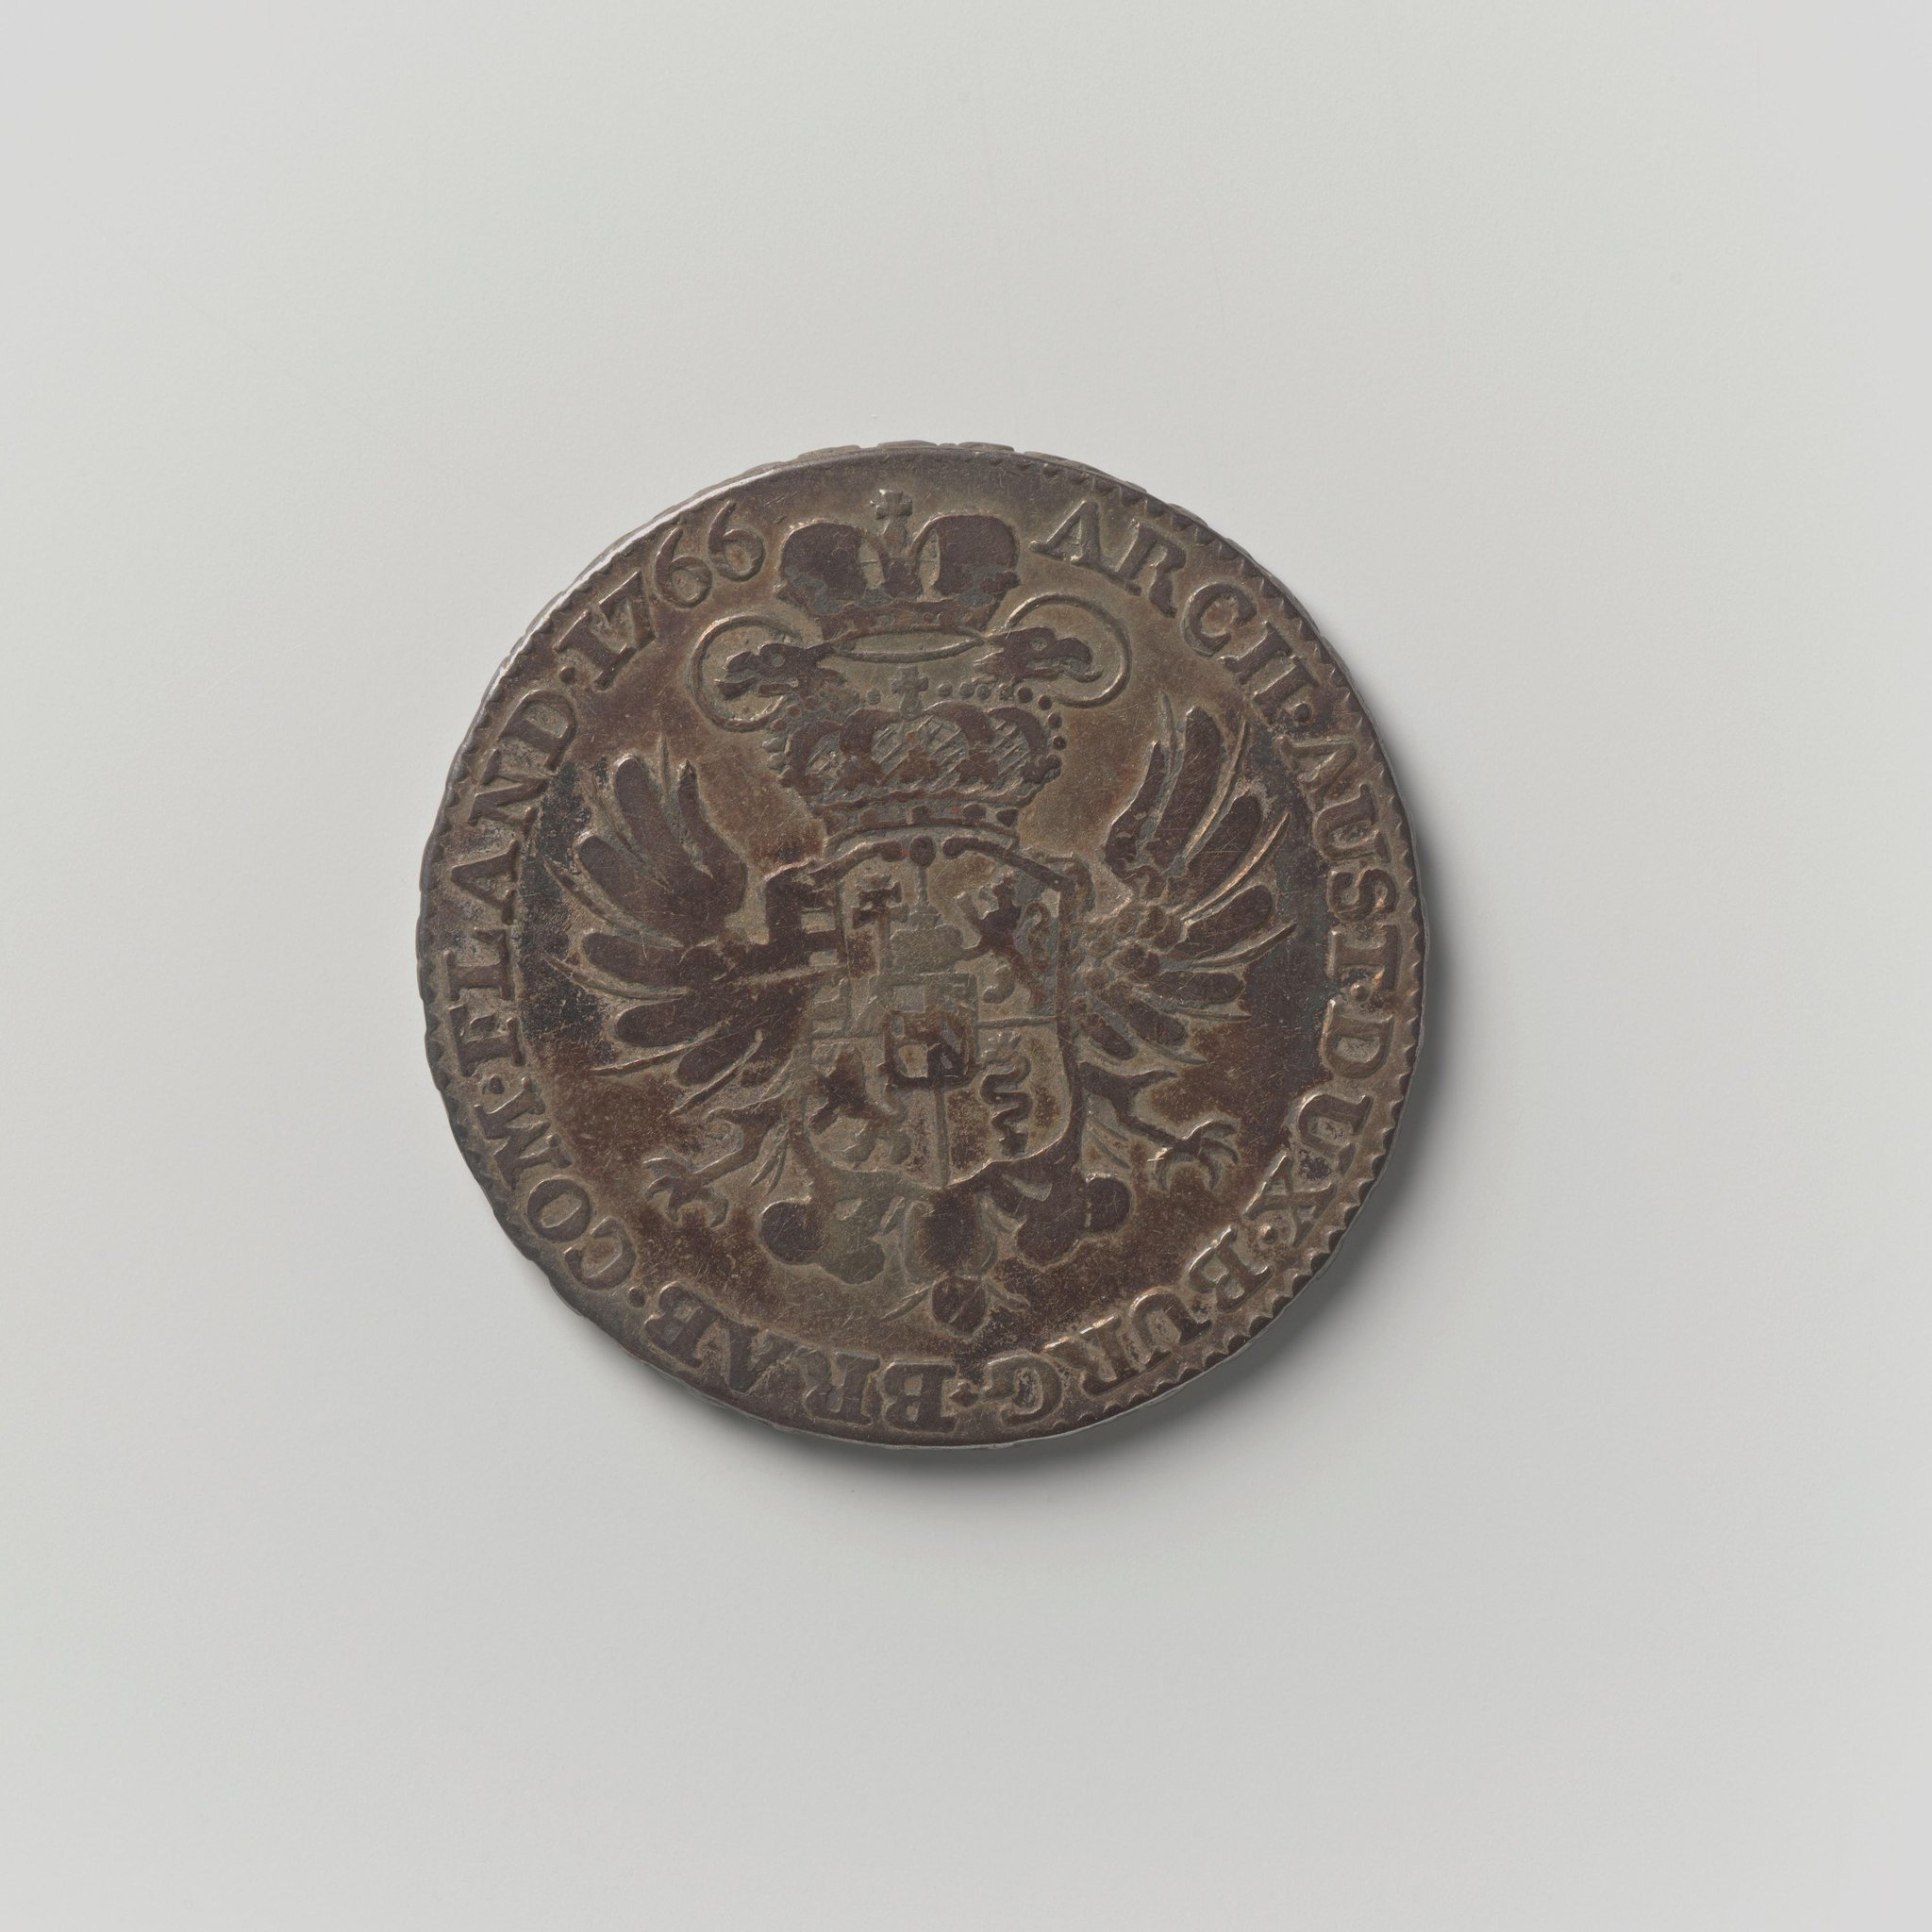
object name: coin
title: Halve kroon uit Brabant van Maria-Theresia,1766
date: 1766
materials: silver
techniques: striking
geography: brussels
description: Zilveren munt. Voorzijde: stokkenkruis. In de hoeken kronen. Boven bovenste kroon engelenkopje. Keerzijde: gekroond samengesteld wapenschild op gekroonde dubbelkoppige adelaar. Jaartal aan het eind van het omschrift. Opliggend randschrift.